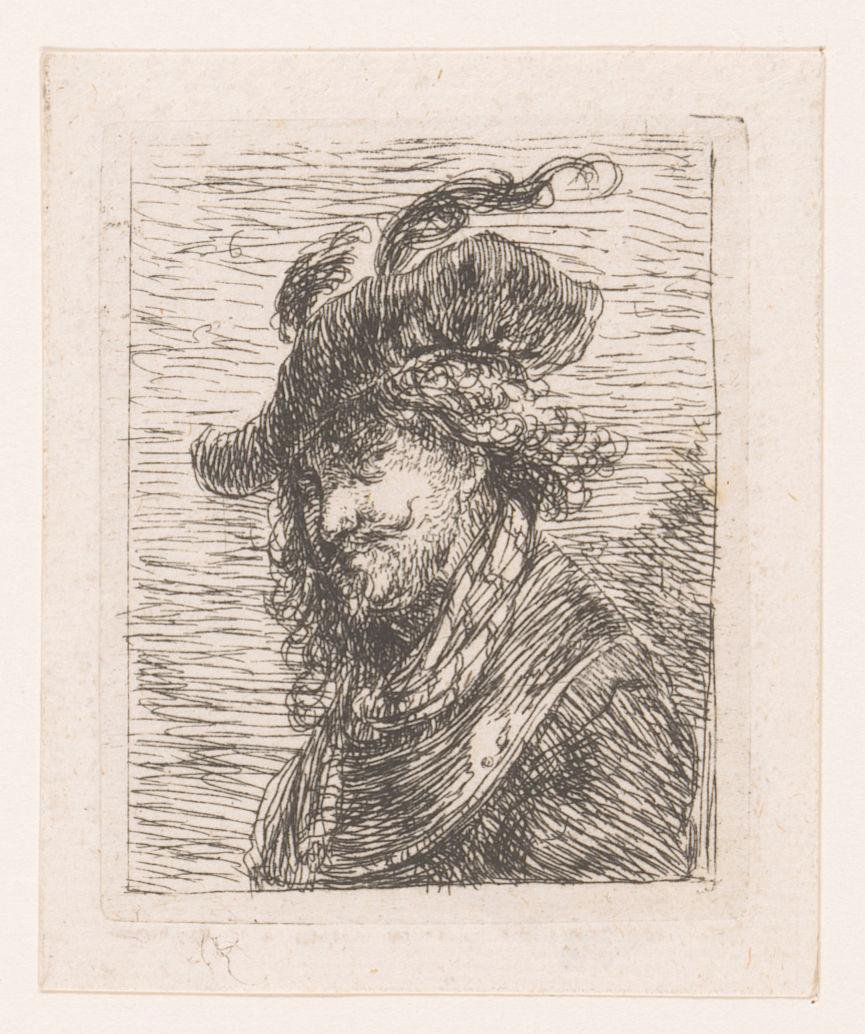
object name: print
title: Buste van man met baret met wapperende pluim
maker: Anonymous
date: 1700-1799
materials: paper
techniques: etching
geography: germany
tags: old man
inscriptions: collector's mark: Lugt 240